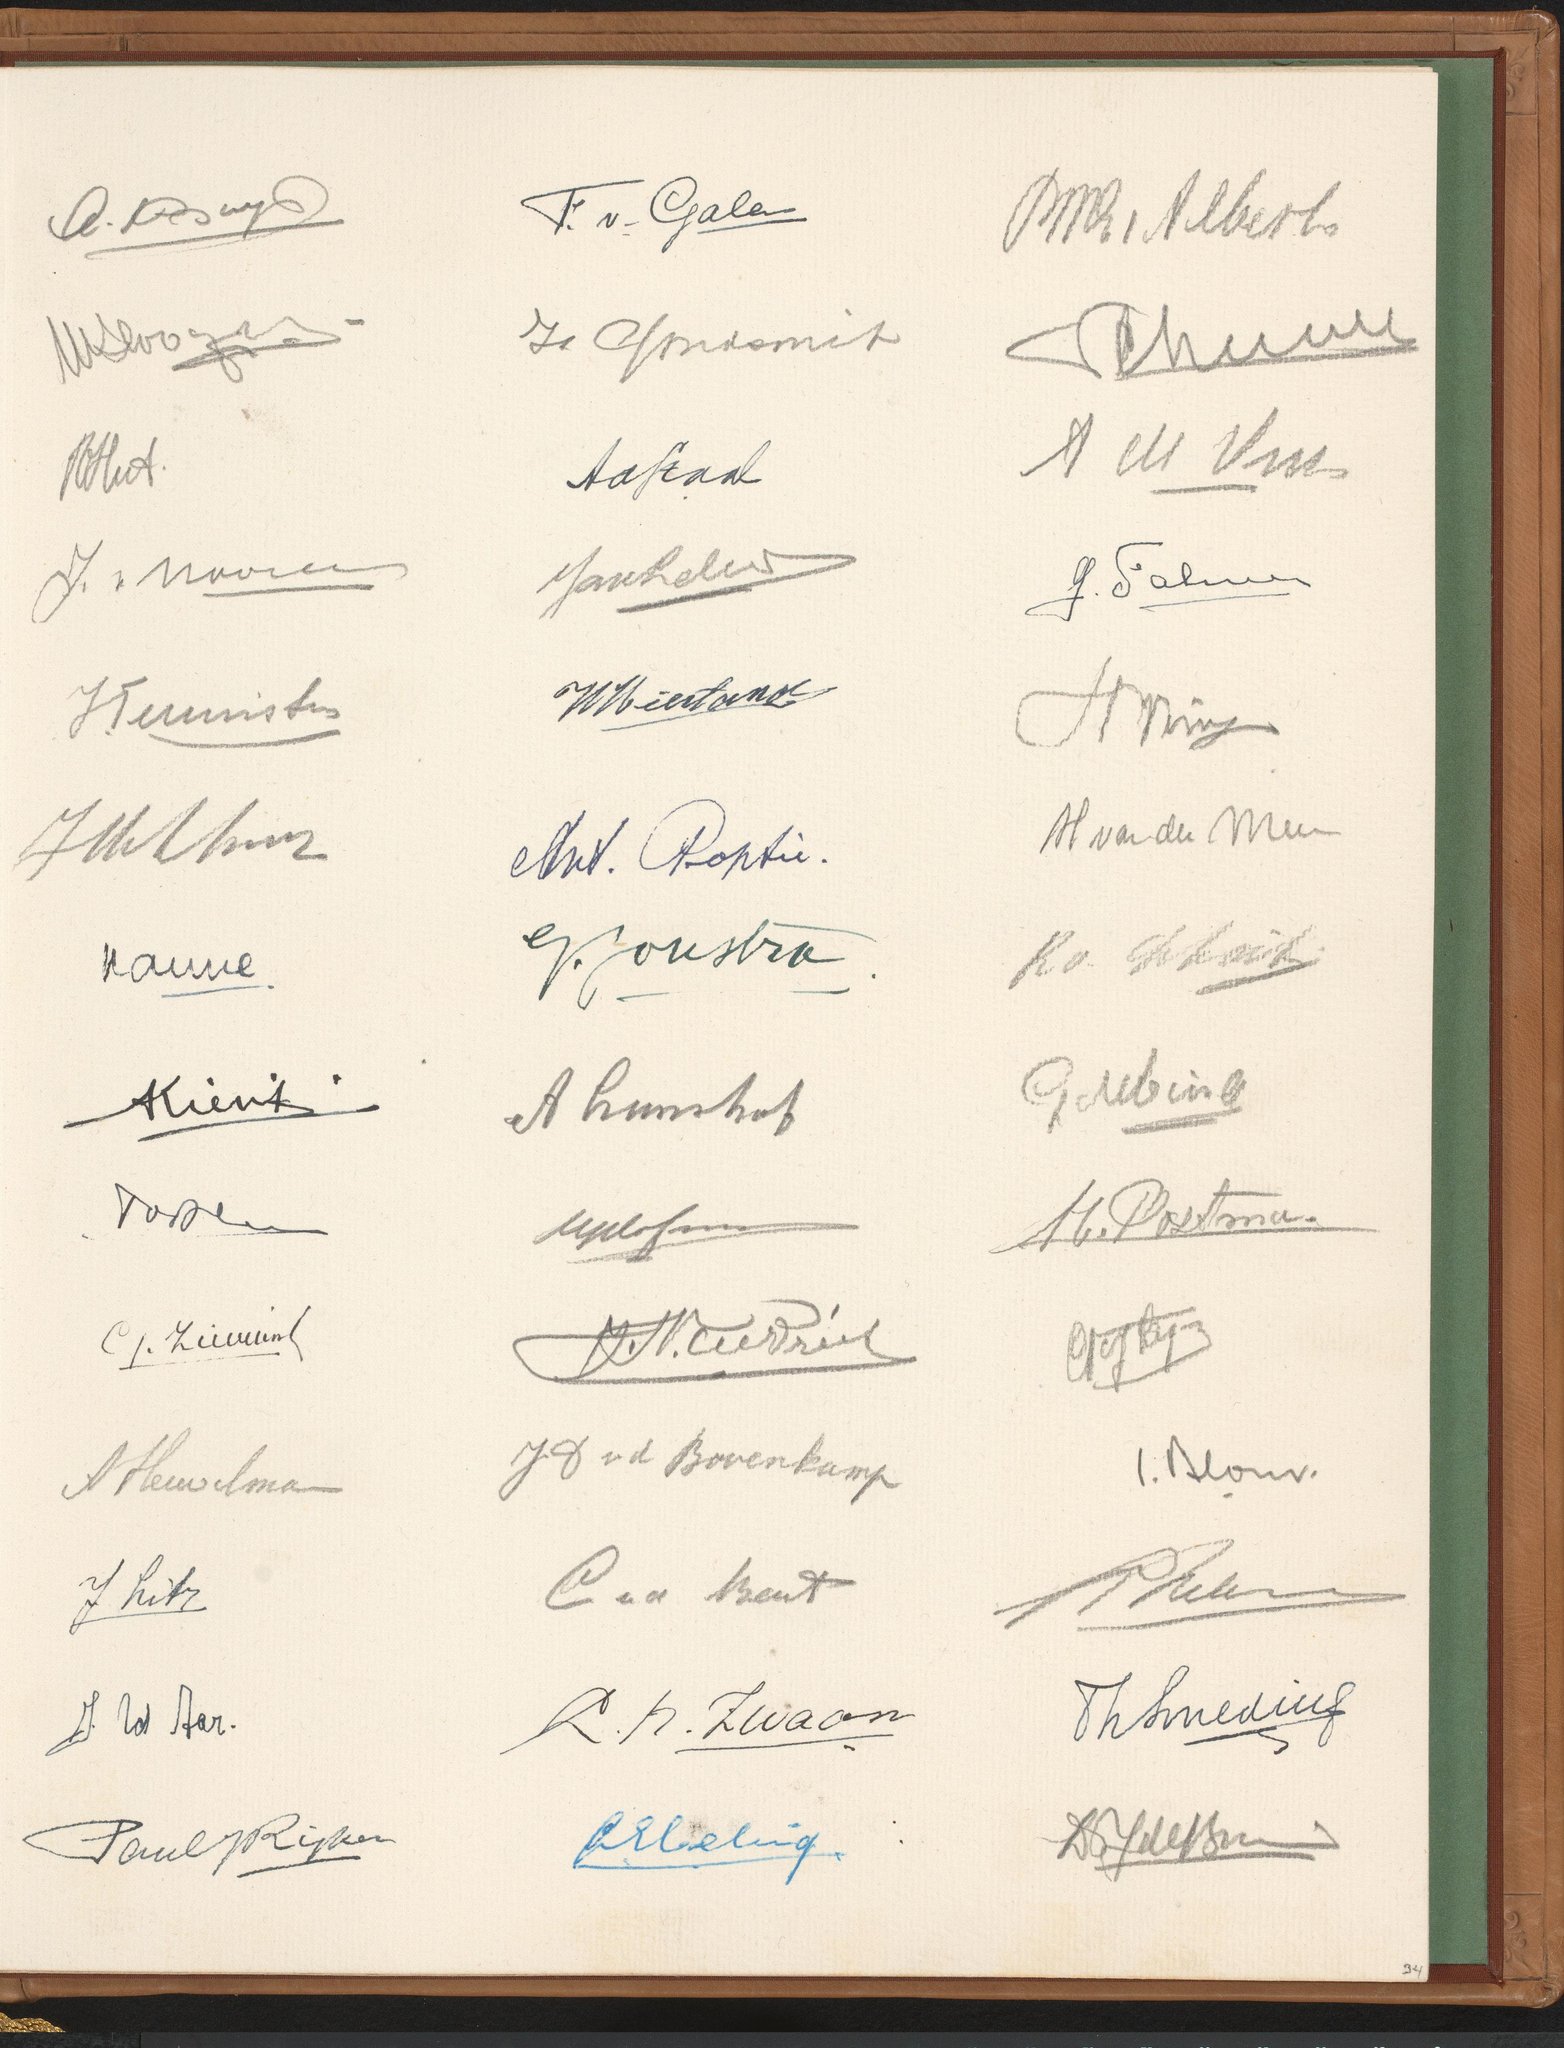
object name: text sheet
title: Blad met handtekeningen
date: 1949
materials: ink, paper, pencil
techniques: handwriting, pen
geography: netherlands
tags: modern professional organization, trade union, reception, cocktail party, handwriting, written text, amsterdam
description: Blad met handtekeningen van aanwezigen op het afscheidsfeest. Onderdeel van het fotoalbum ter gelegenheid van het afscheid van Evert Kupers als voorzitter van de NVV op 14 juli 1949 in Amsterdam.